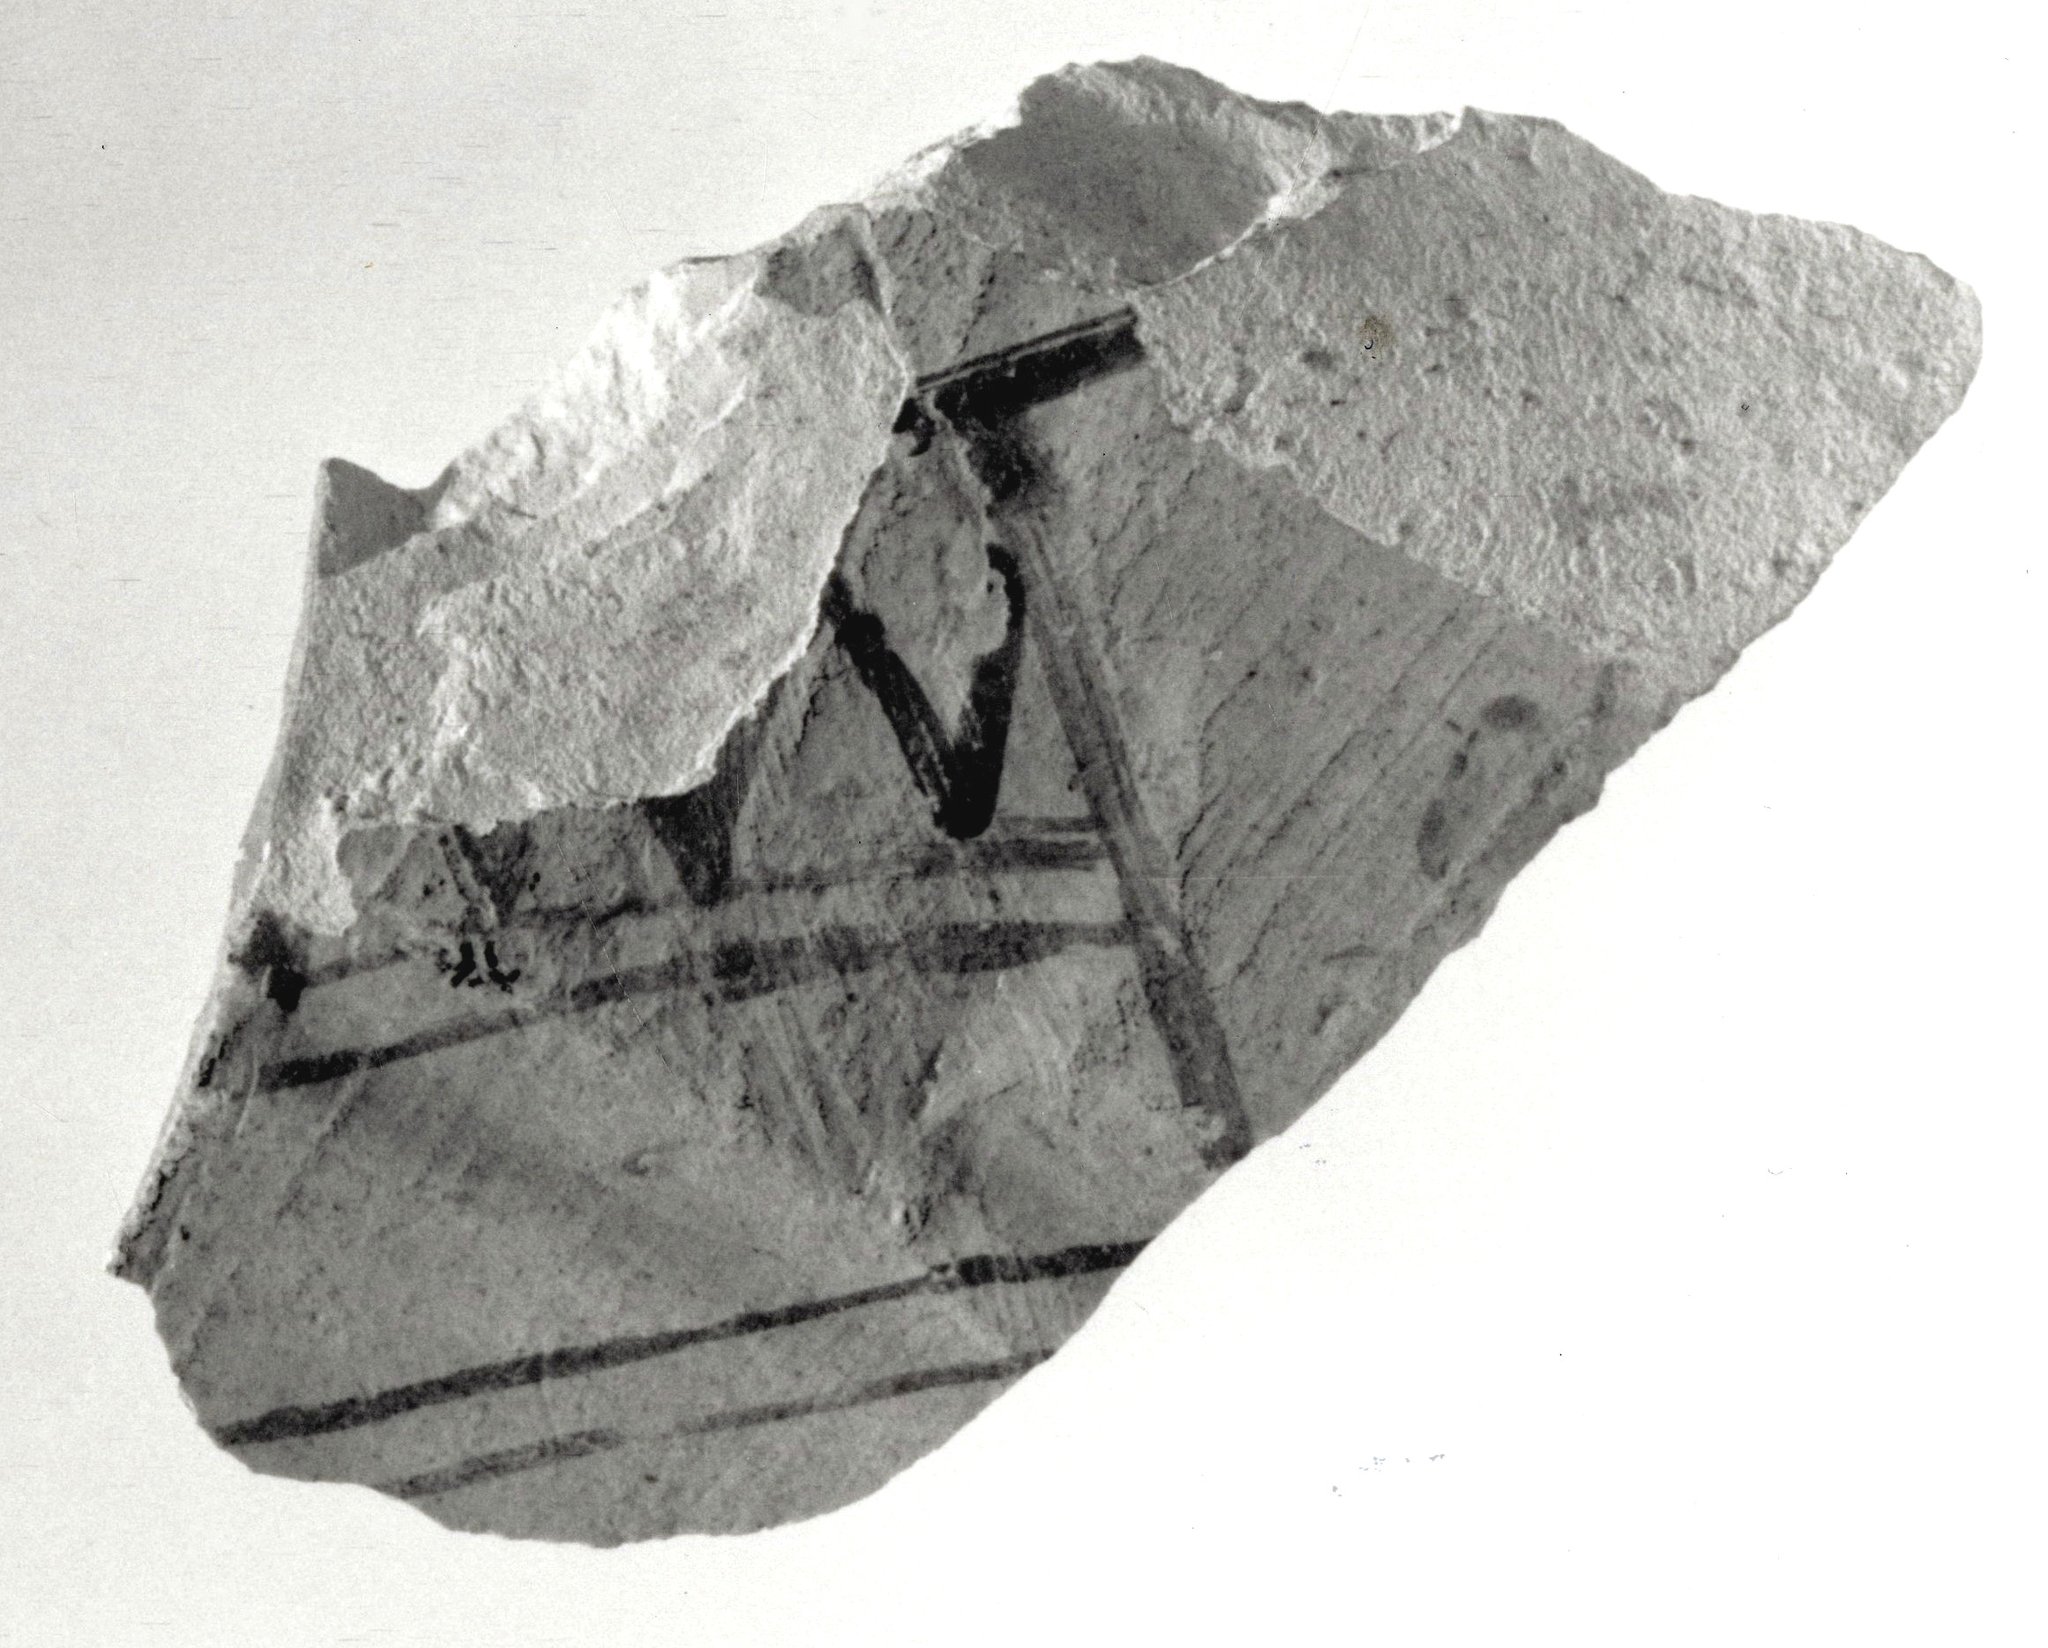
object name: relief, tomb of nespekashuty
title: Drawing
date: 664-610 BCE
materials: limestone, varnish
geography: egypt